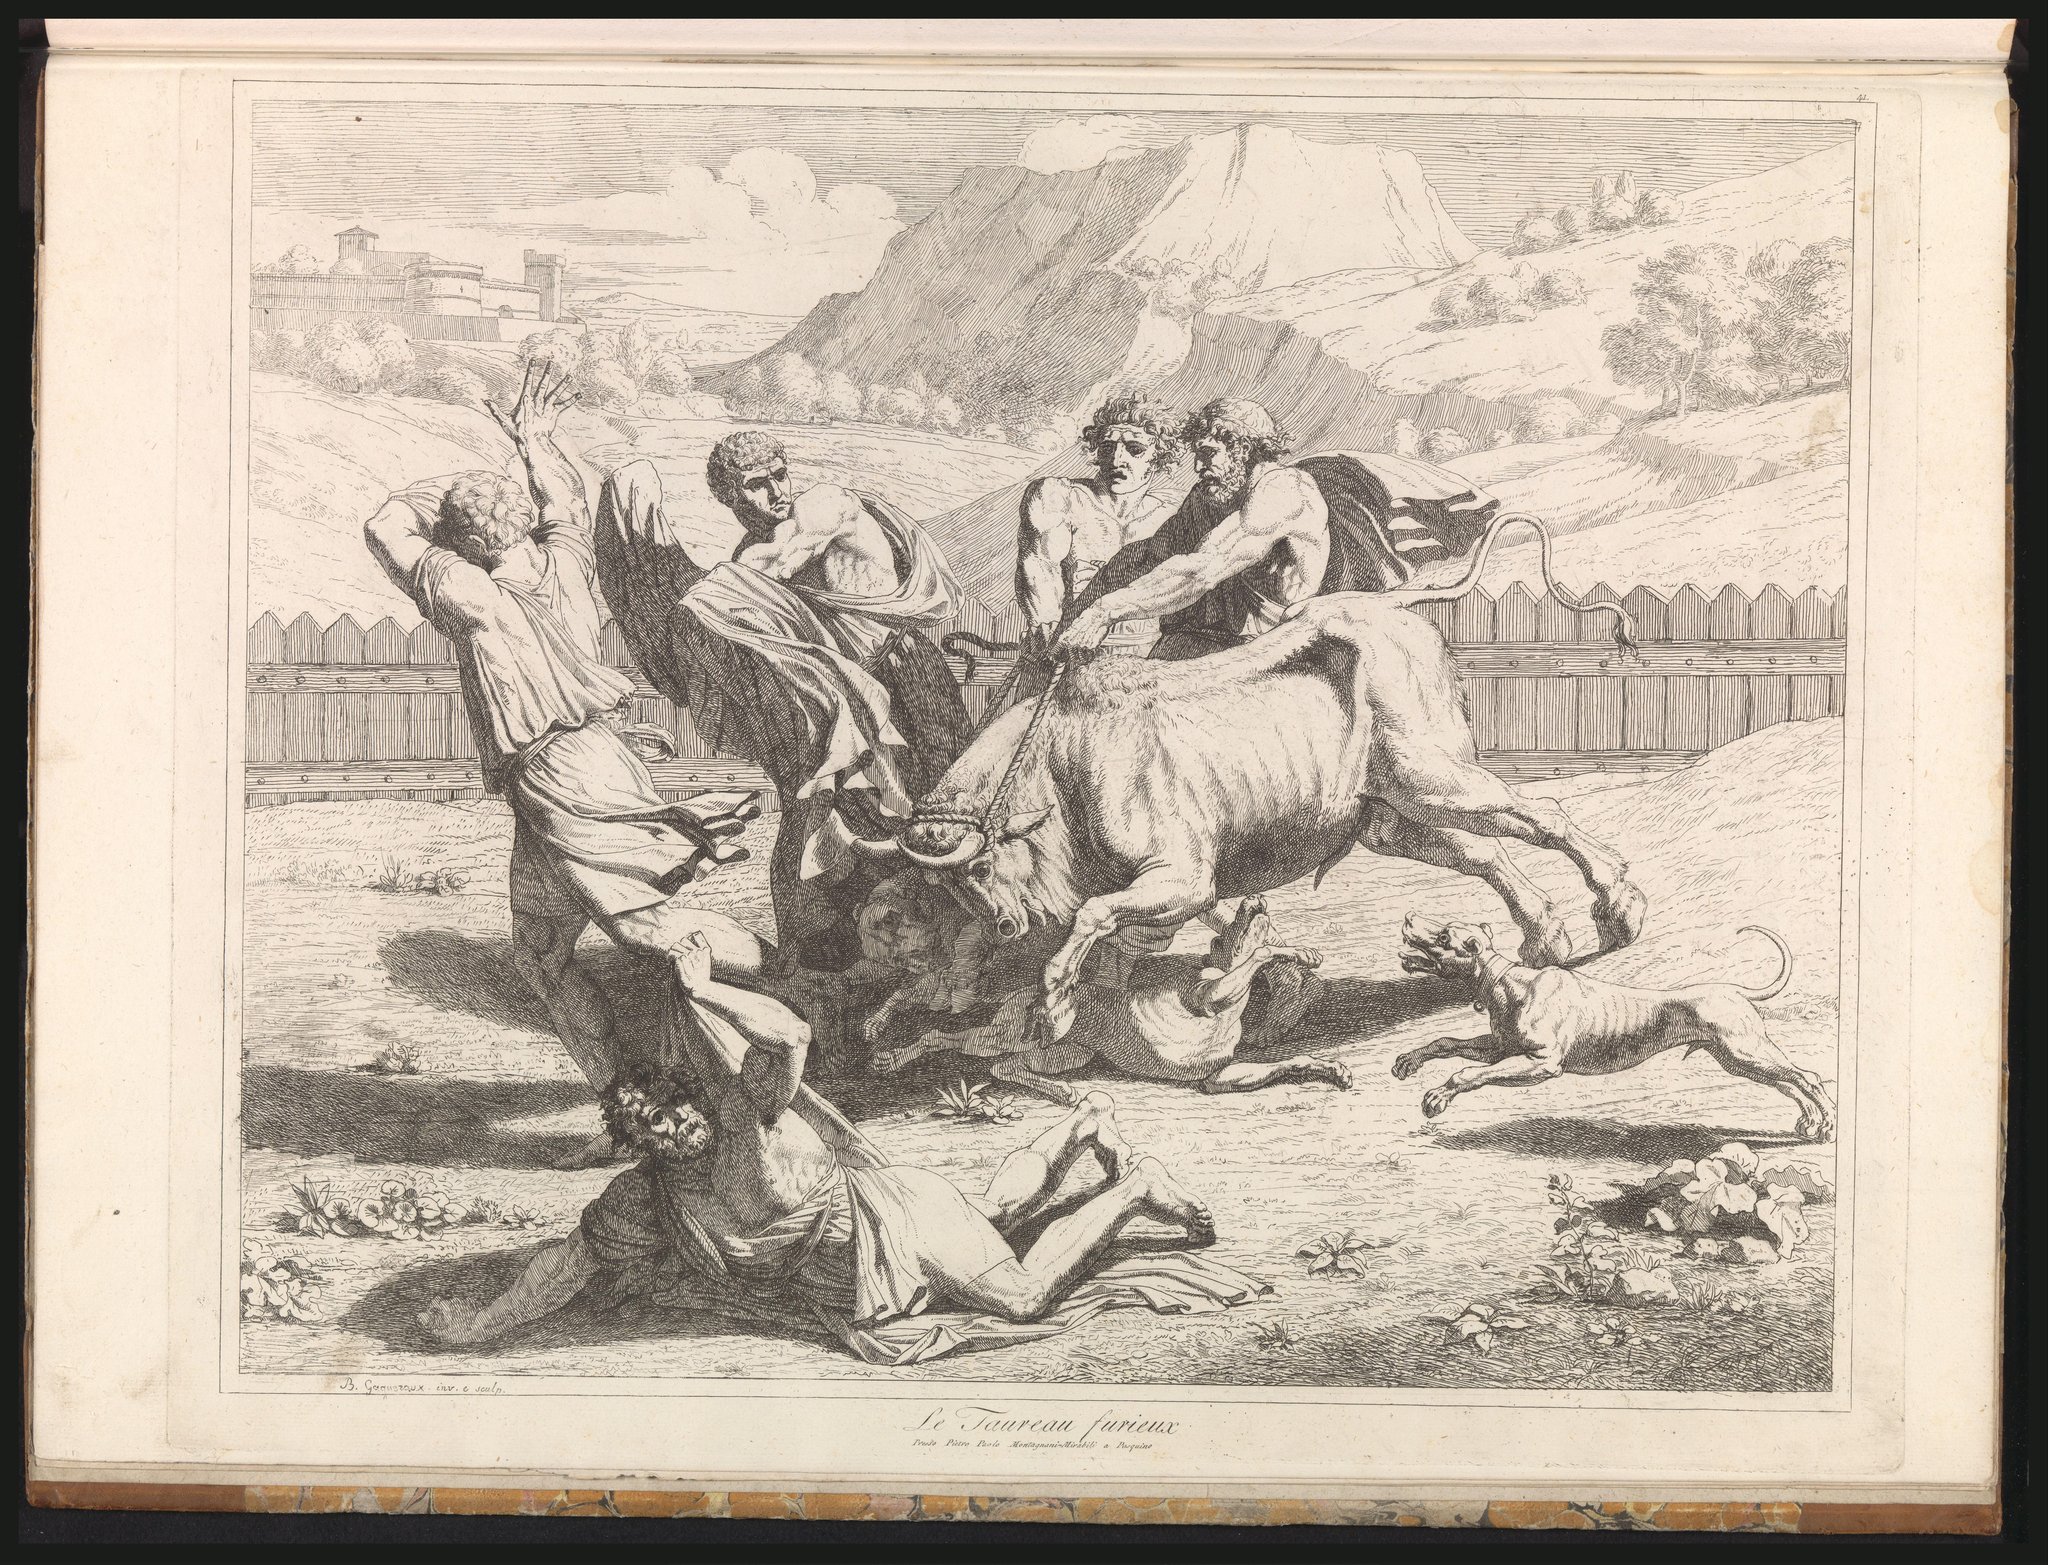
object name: print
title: De woeste stier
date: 1804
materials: paper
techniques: etching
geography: rome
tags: bull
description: Een groep mannen worstelt om een woeste stier in bedwang te houden. Prent nr. 41 op blad 26 in het album 'Raccolta di Soggetti Pittorici', een prentalbum met 42 genummerde etsen op 28 pagina's van Luigi Sabatelli (I) zelf en van leerlingen naar diens ontwerp.